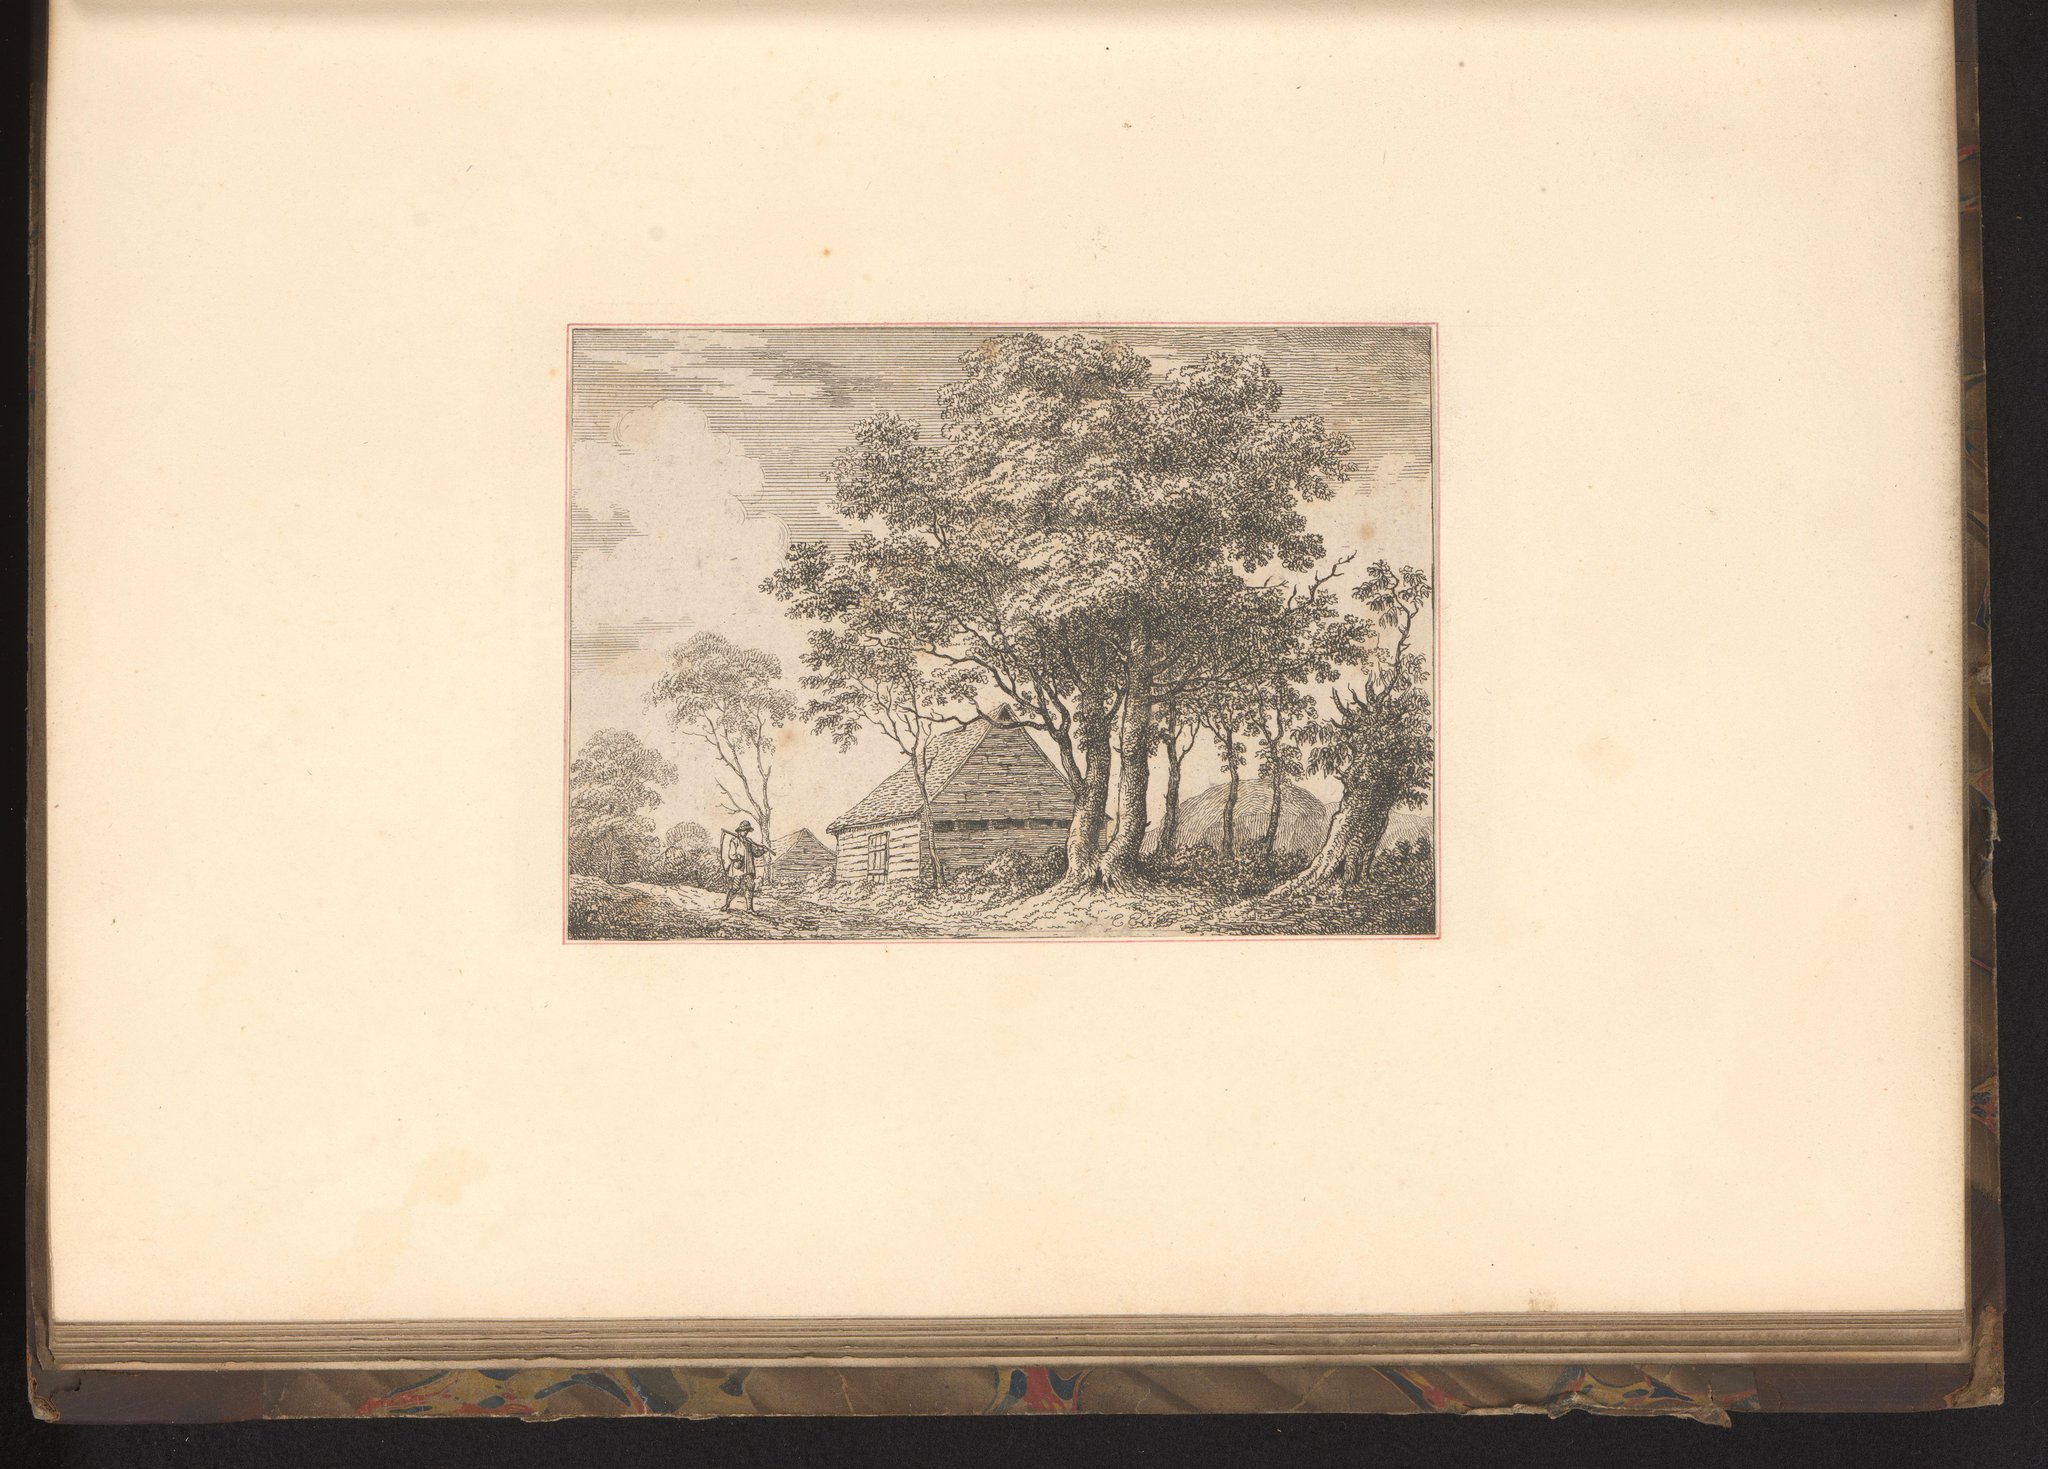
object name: print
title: Landschap met een schuur en man met zeis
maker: edward edwards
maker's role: painter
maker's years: 1738-1806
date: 1748-1806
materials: paper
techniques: etching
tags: agricultural implements: scythe, landscapes (+ landscape with figures, staffage), farm (building)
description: Prent maakt deel uit van een serie van 51 prenten, bestaande uit twee delen met landschappen (36 prenten) en figuren en portretten (15 prenten), voor het eerst uitgegeven in Londen in 1790.